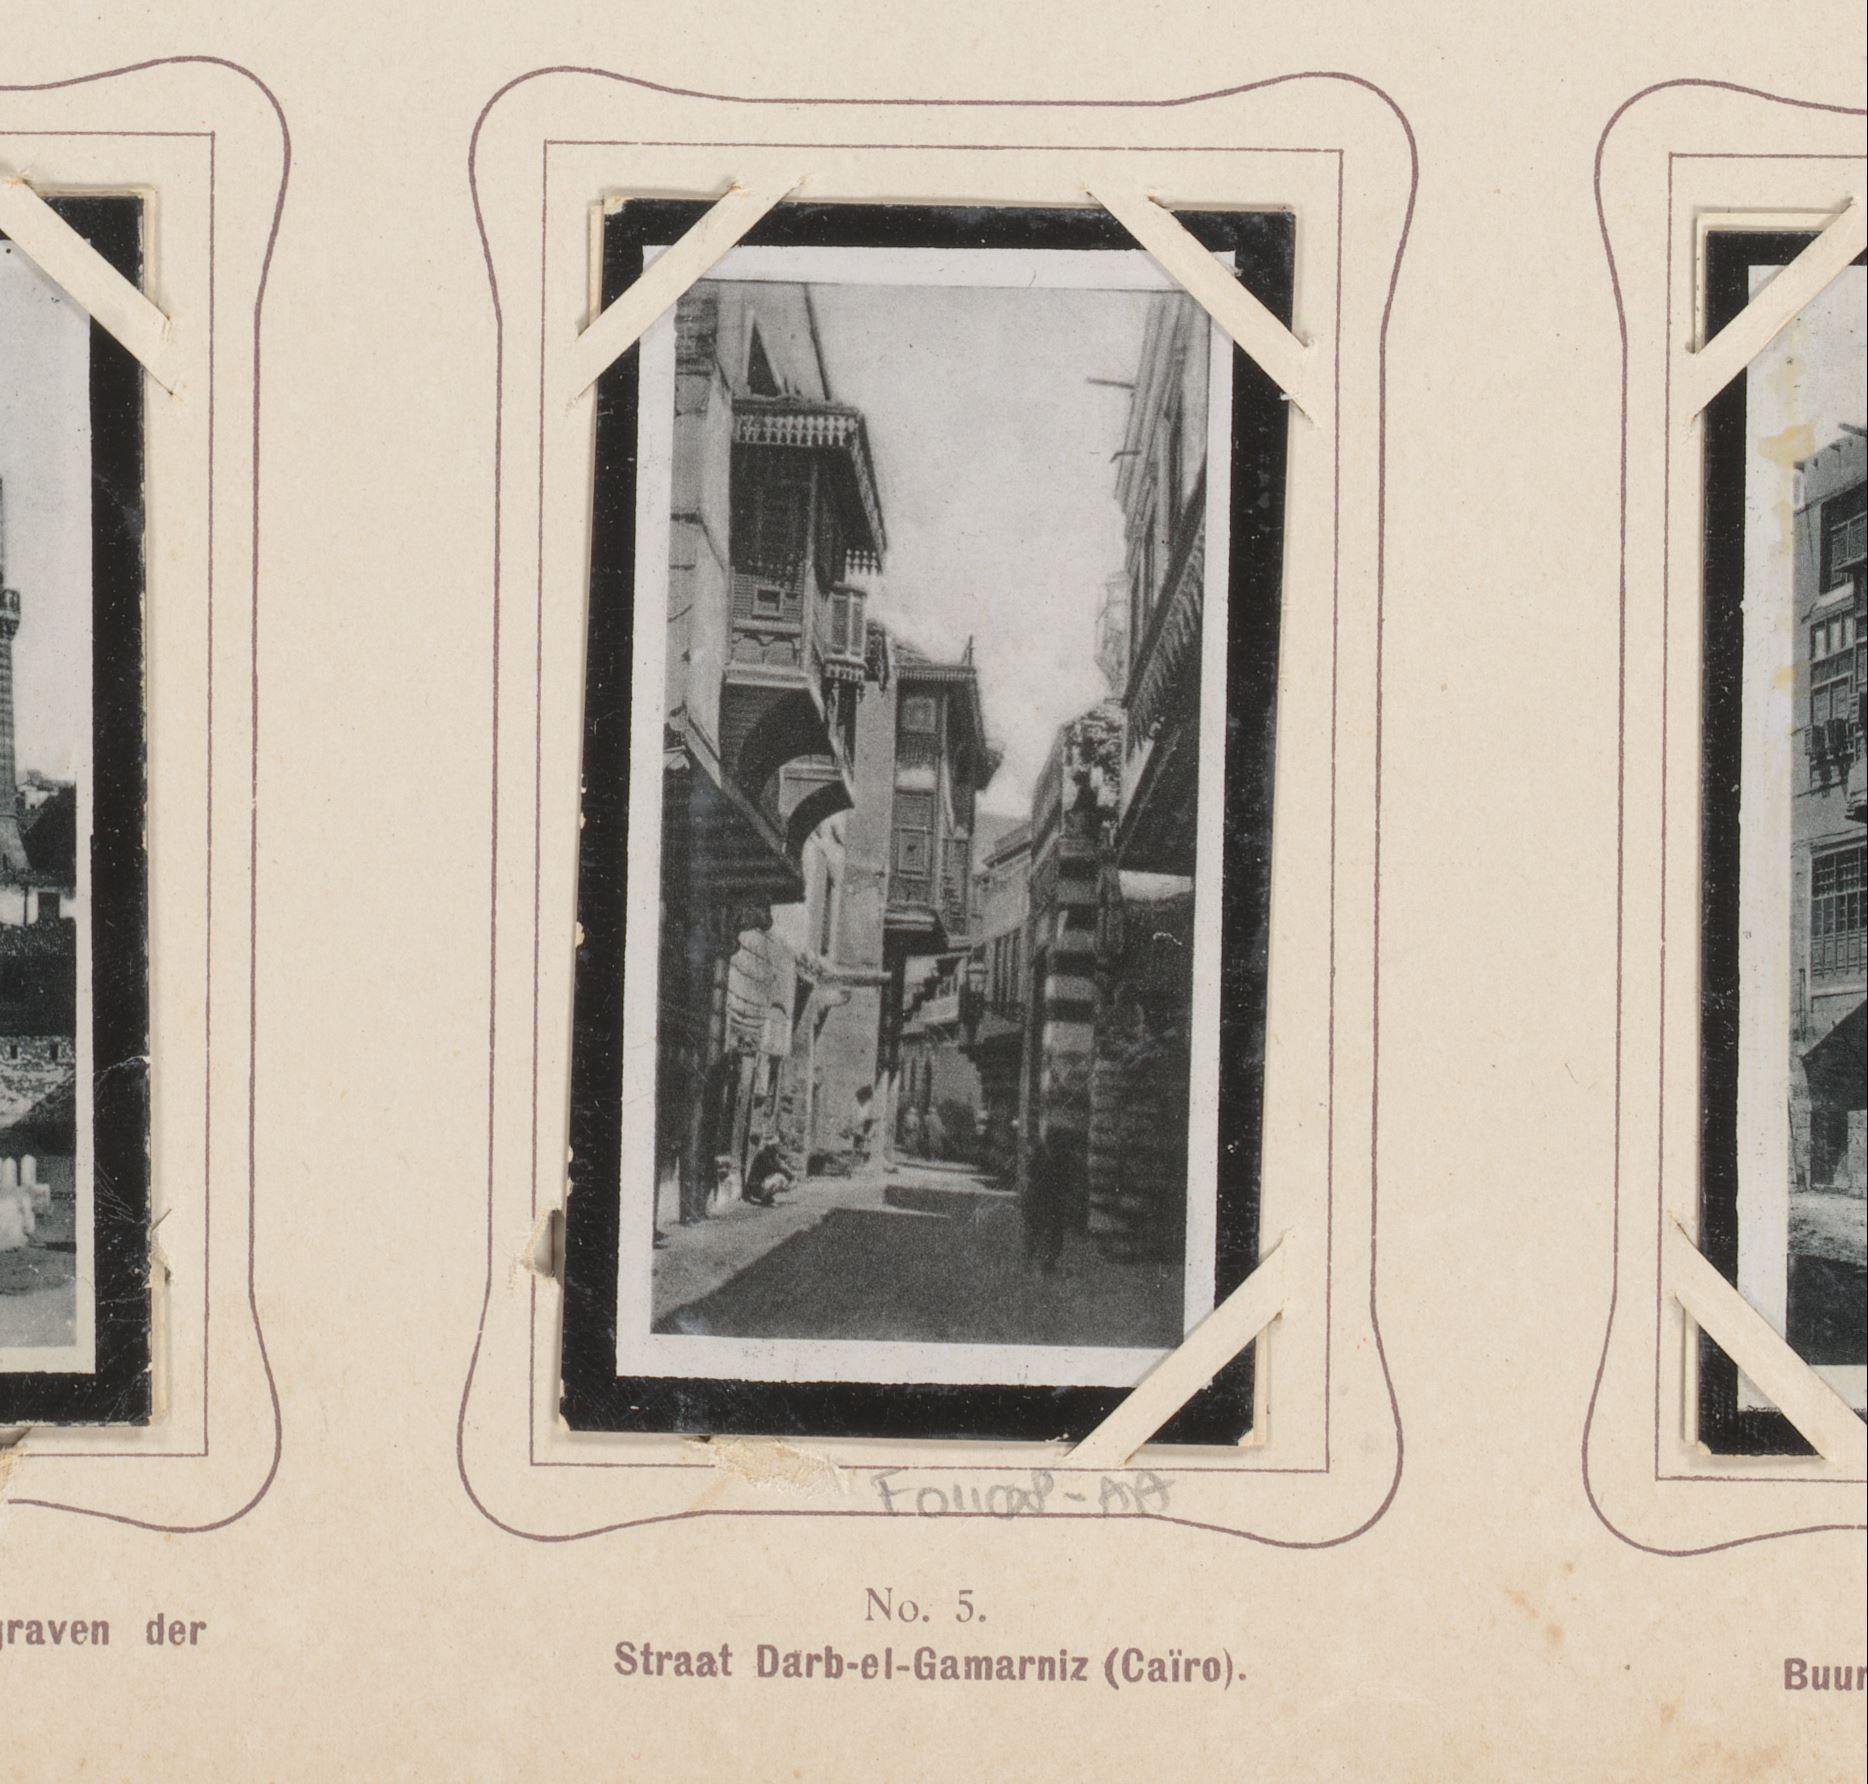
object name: photomechanical print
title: Straatgezicht te Caïro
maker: Anonymous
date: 1906-1907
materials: paper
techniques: photograph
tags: street (+ city(-scape) with figures, staffage)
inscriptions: inscription: ‘No. 5./ Straat Darb-el-Gamarniz (Caïro).’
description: Deze prent maakt deel uit van een album.